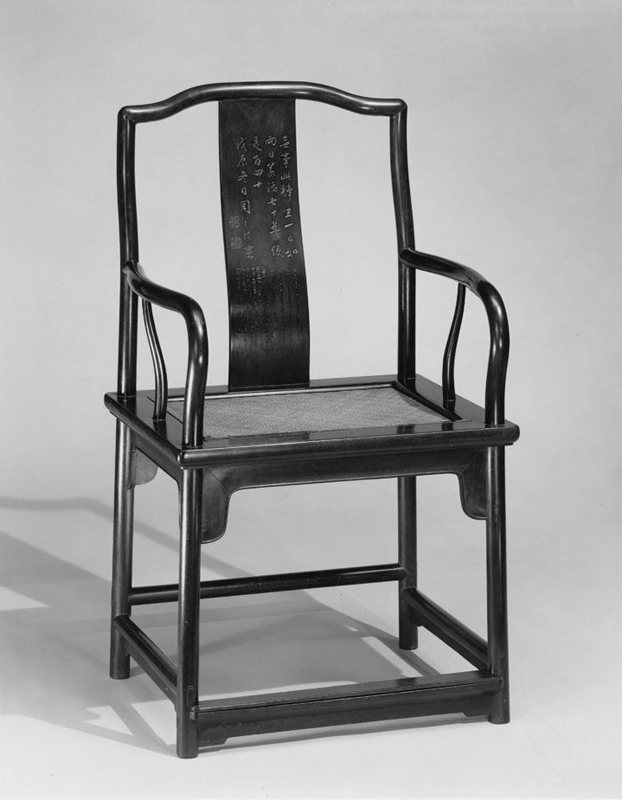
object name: armchair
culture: chinese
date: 1601-1700